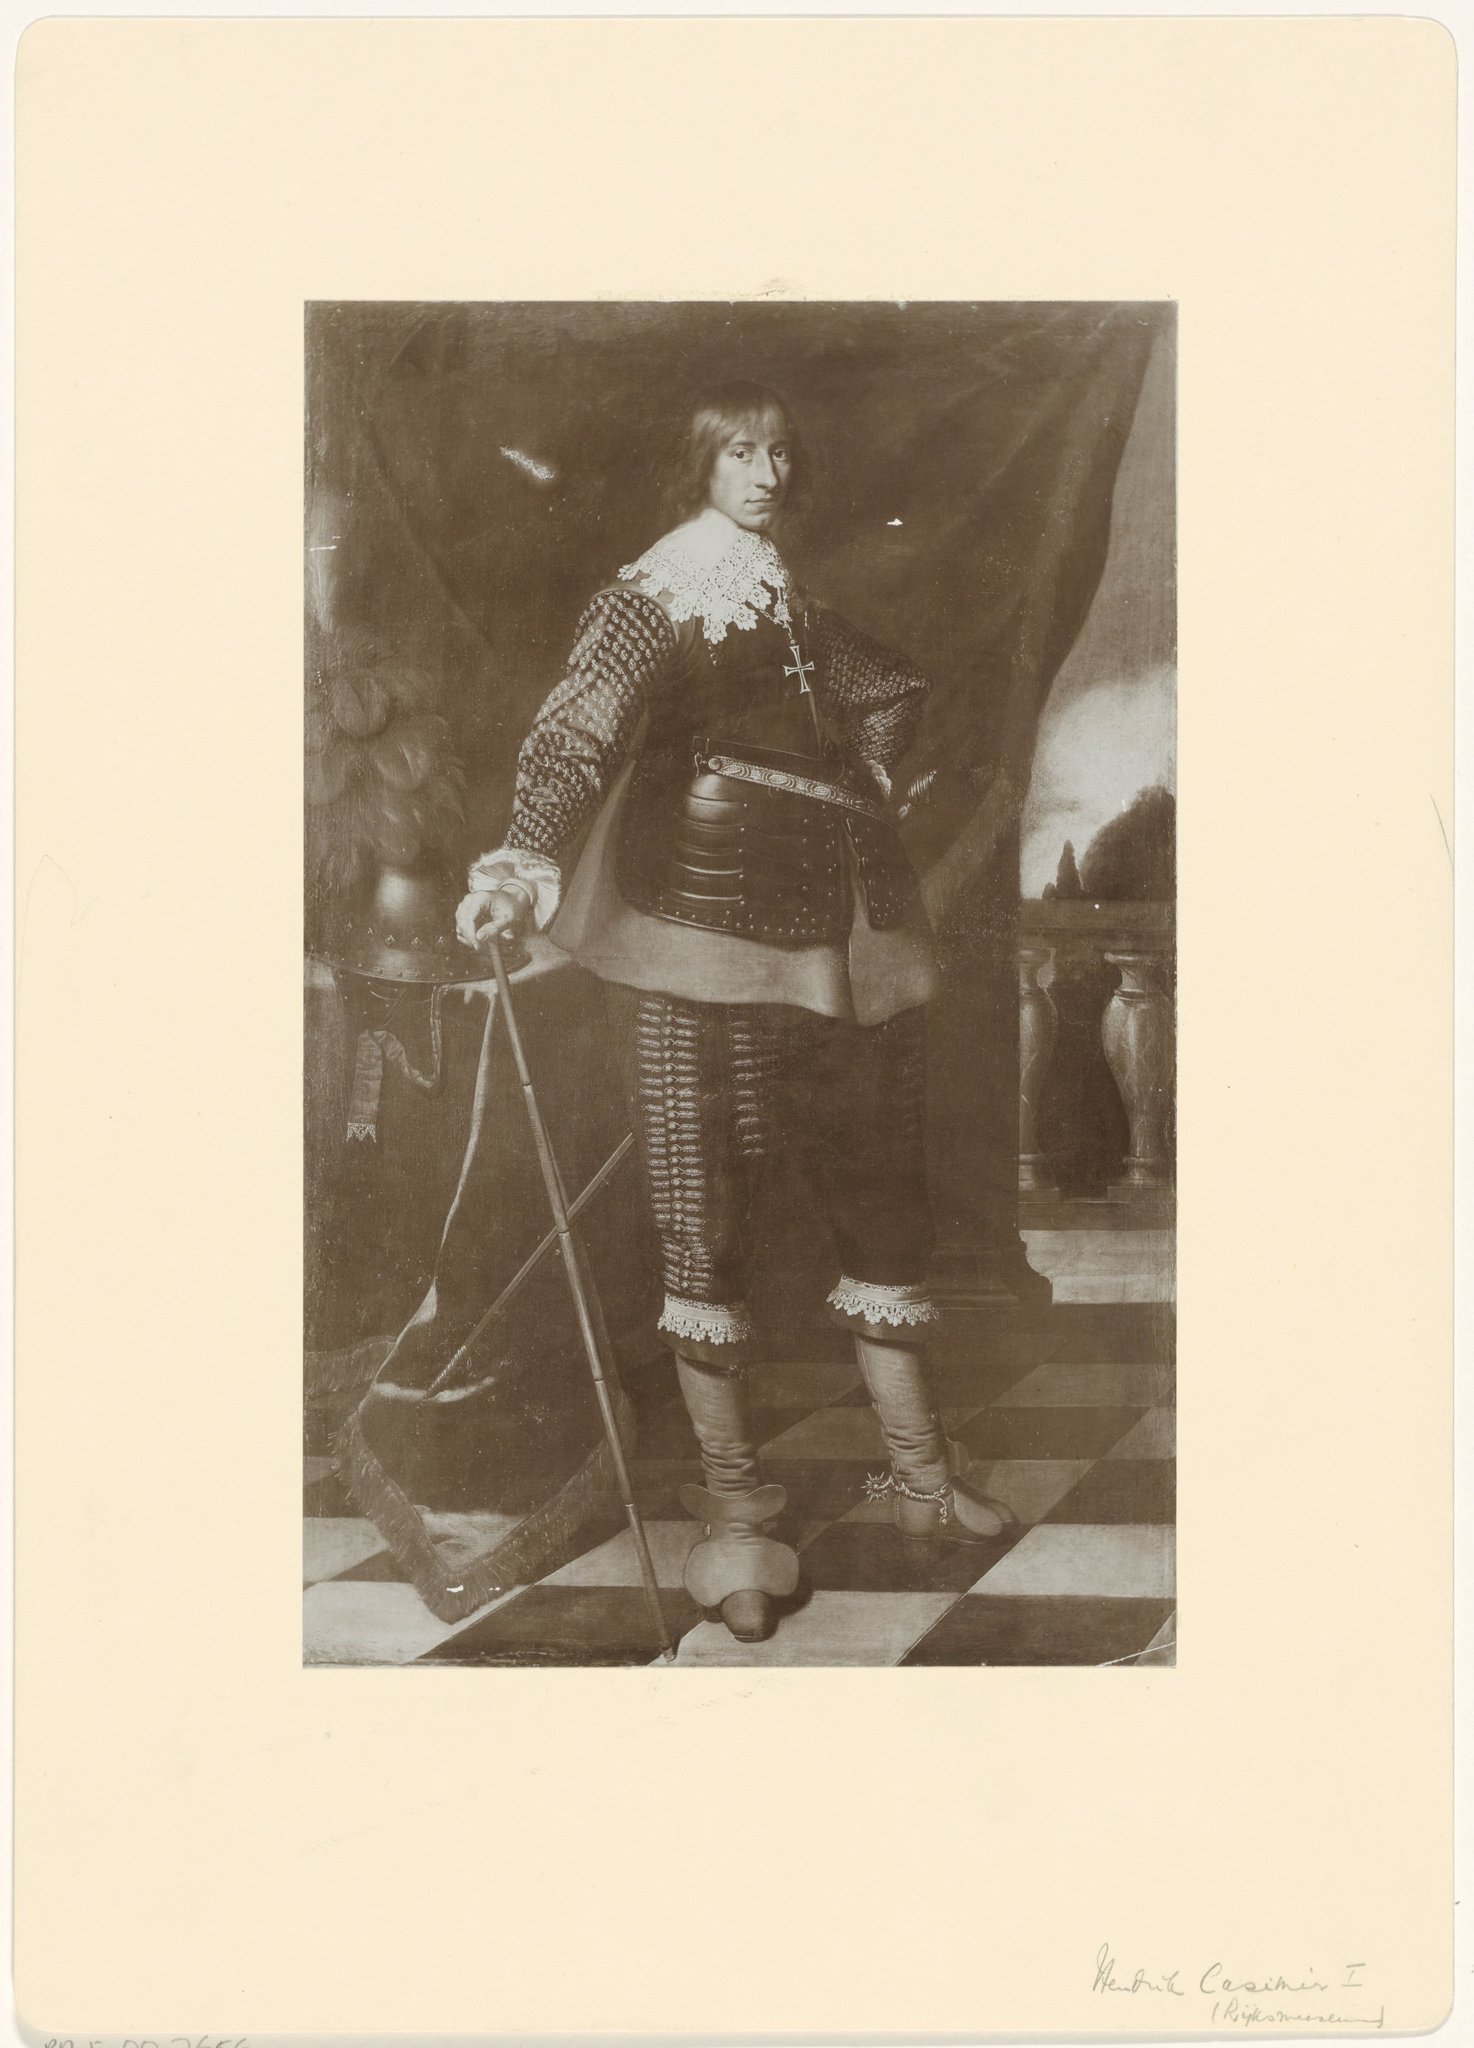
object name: photograph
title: Portret van Hendrik Casimir I, graaf van Nassau-Dietz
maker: Anonymous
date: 1850-1930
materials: photographic support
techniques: collodion silver print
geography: netherlands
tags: hendrik casimir i graaf van nassau-dietz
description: De hier vermelde titel verwijst naar de hoogst verkregen titel van de geportretteerde, niet per se naar de titel die de geportretteerde op deze voorstelling draagt.